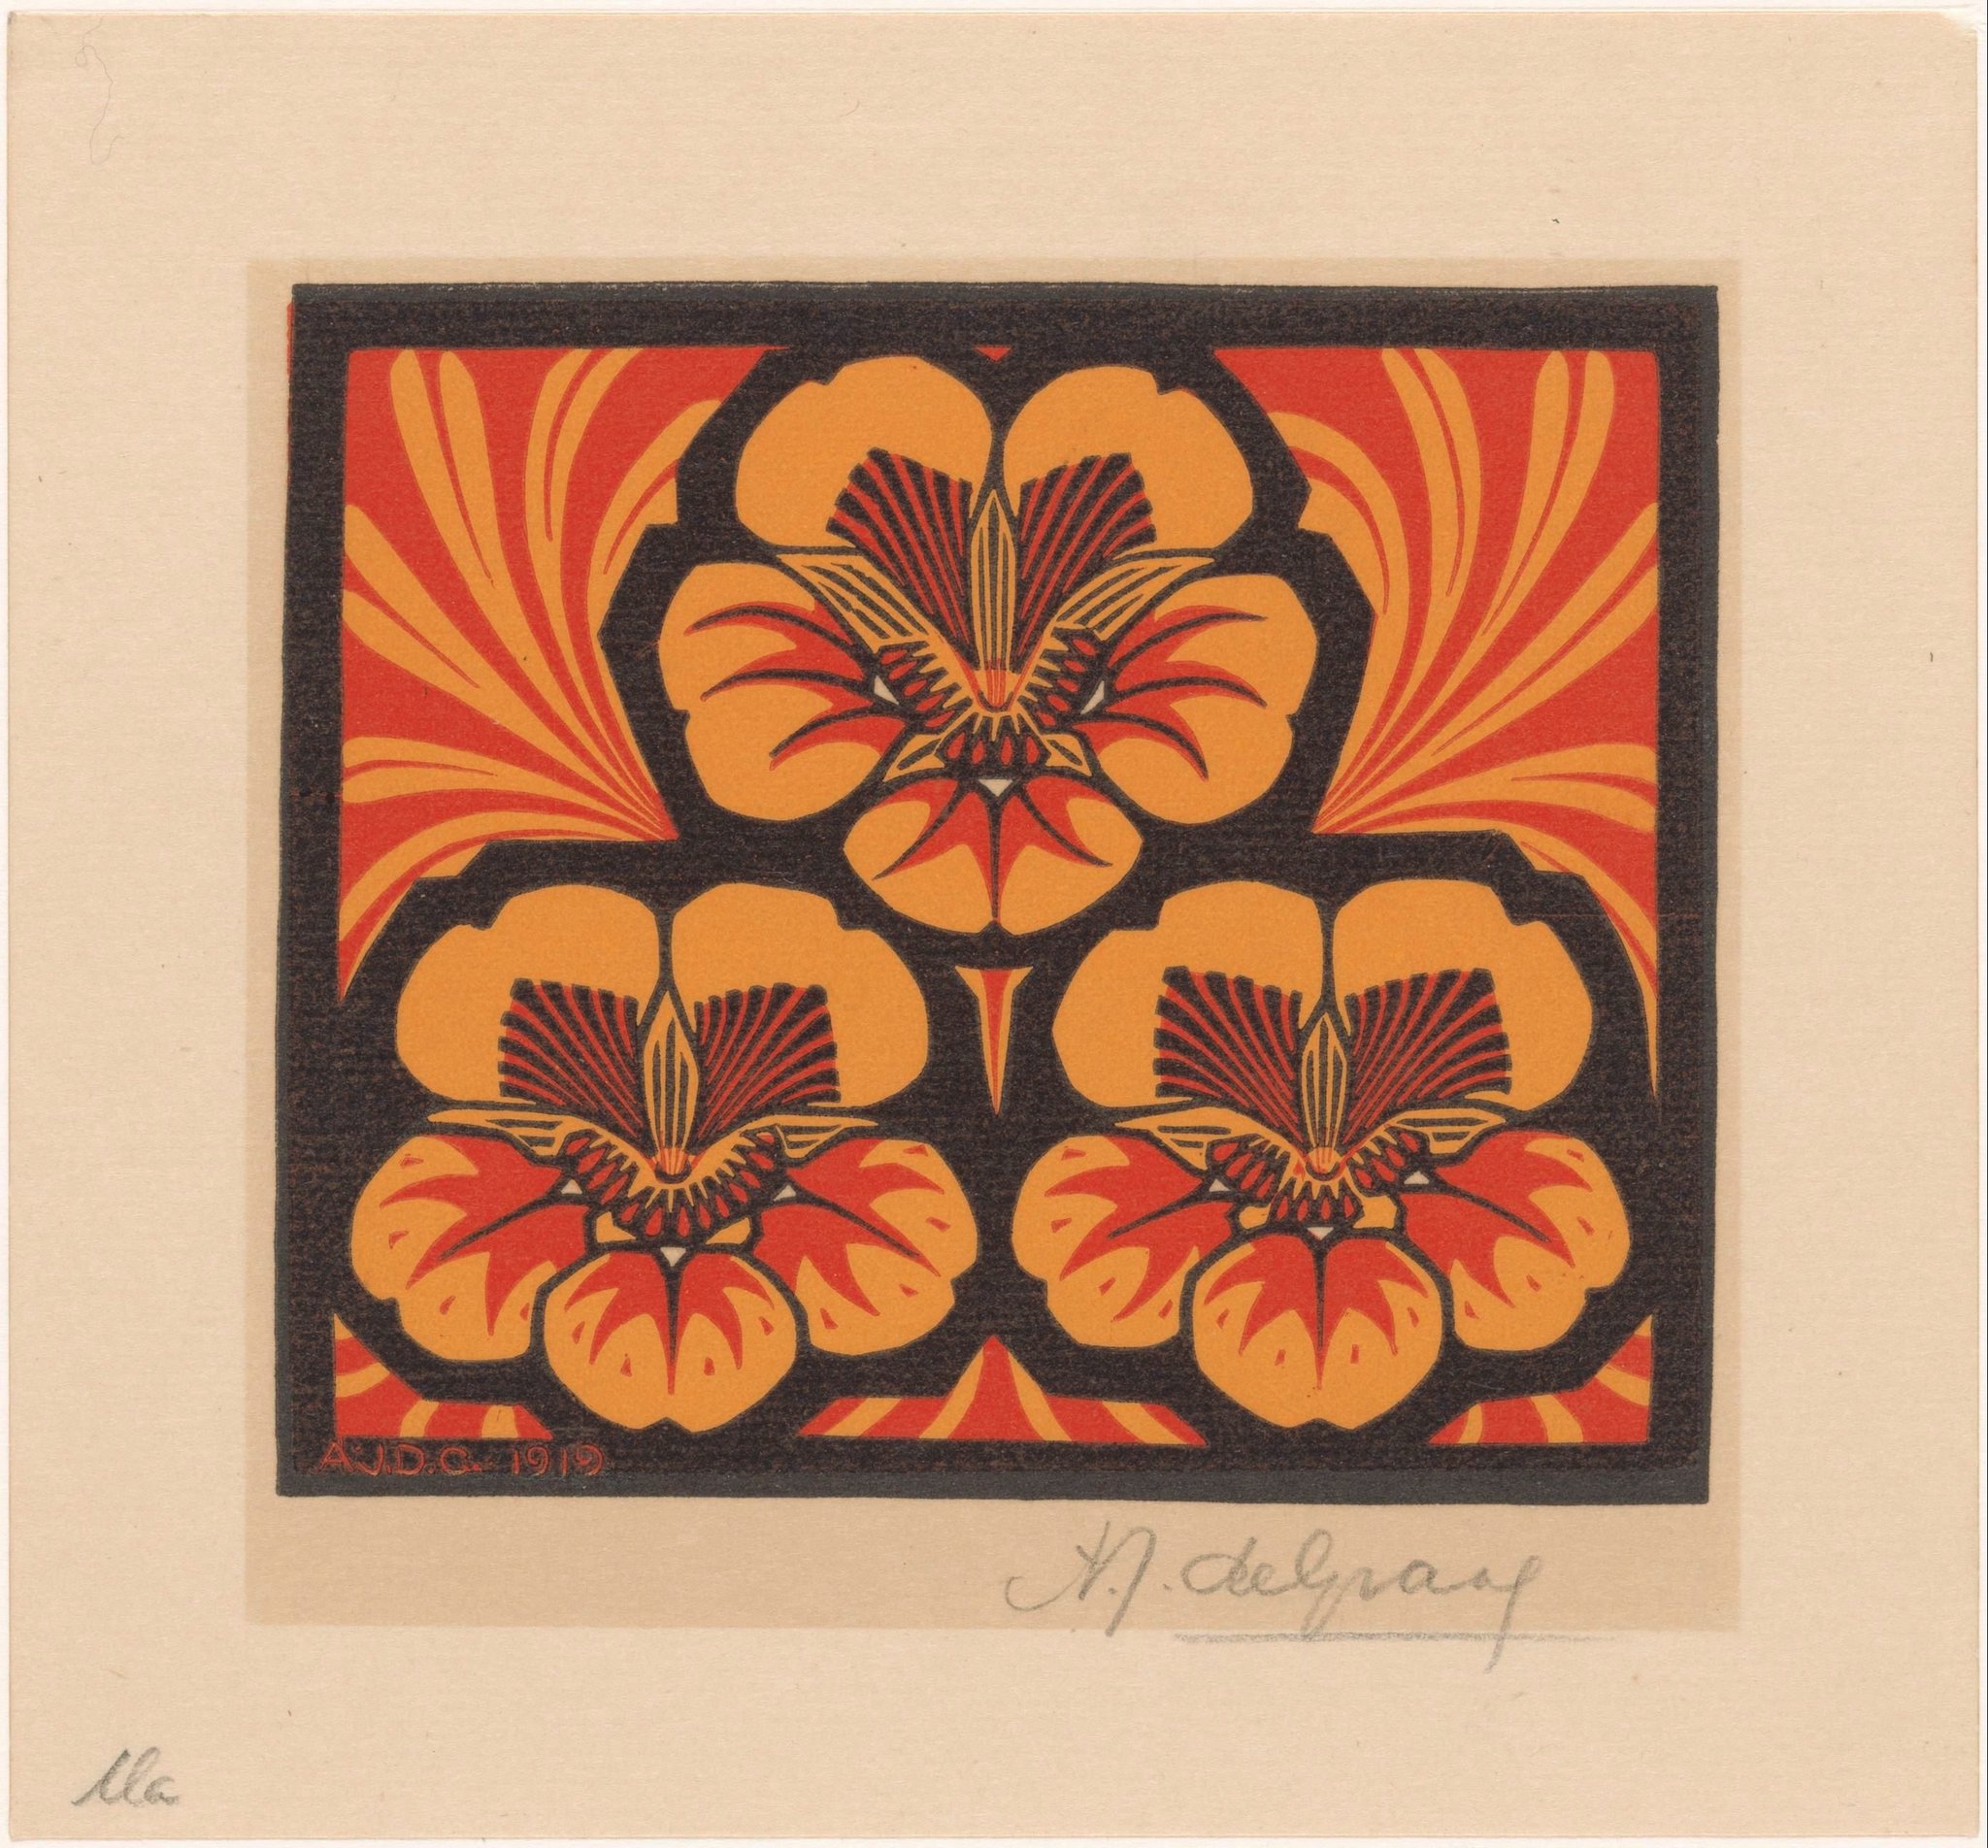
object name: print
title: Oost-Indische kers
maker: julie de graag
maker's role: draughtsman, print maker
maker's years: 1877-1924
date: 1919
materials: paper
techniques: woodcut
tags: flowers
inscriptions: collector's mark: Lugt 2228